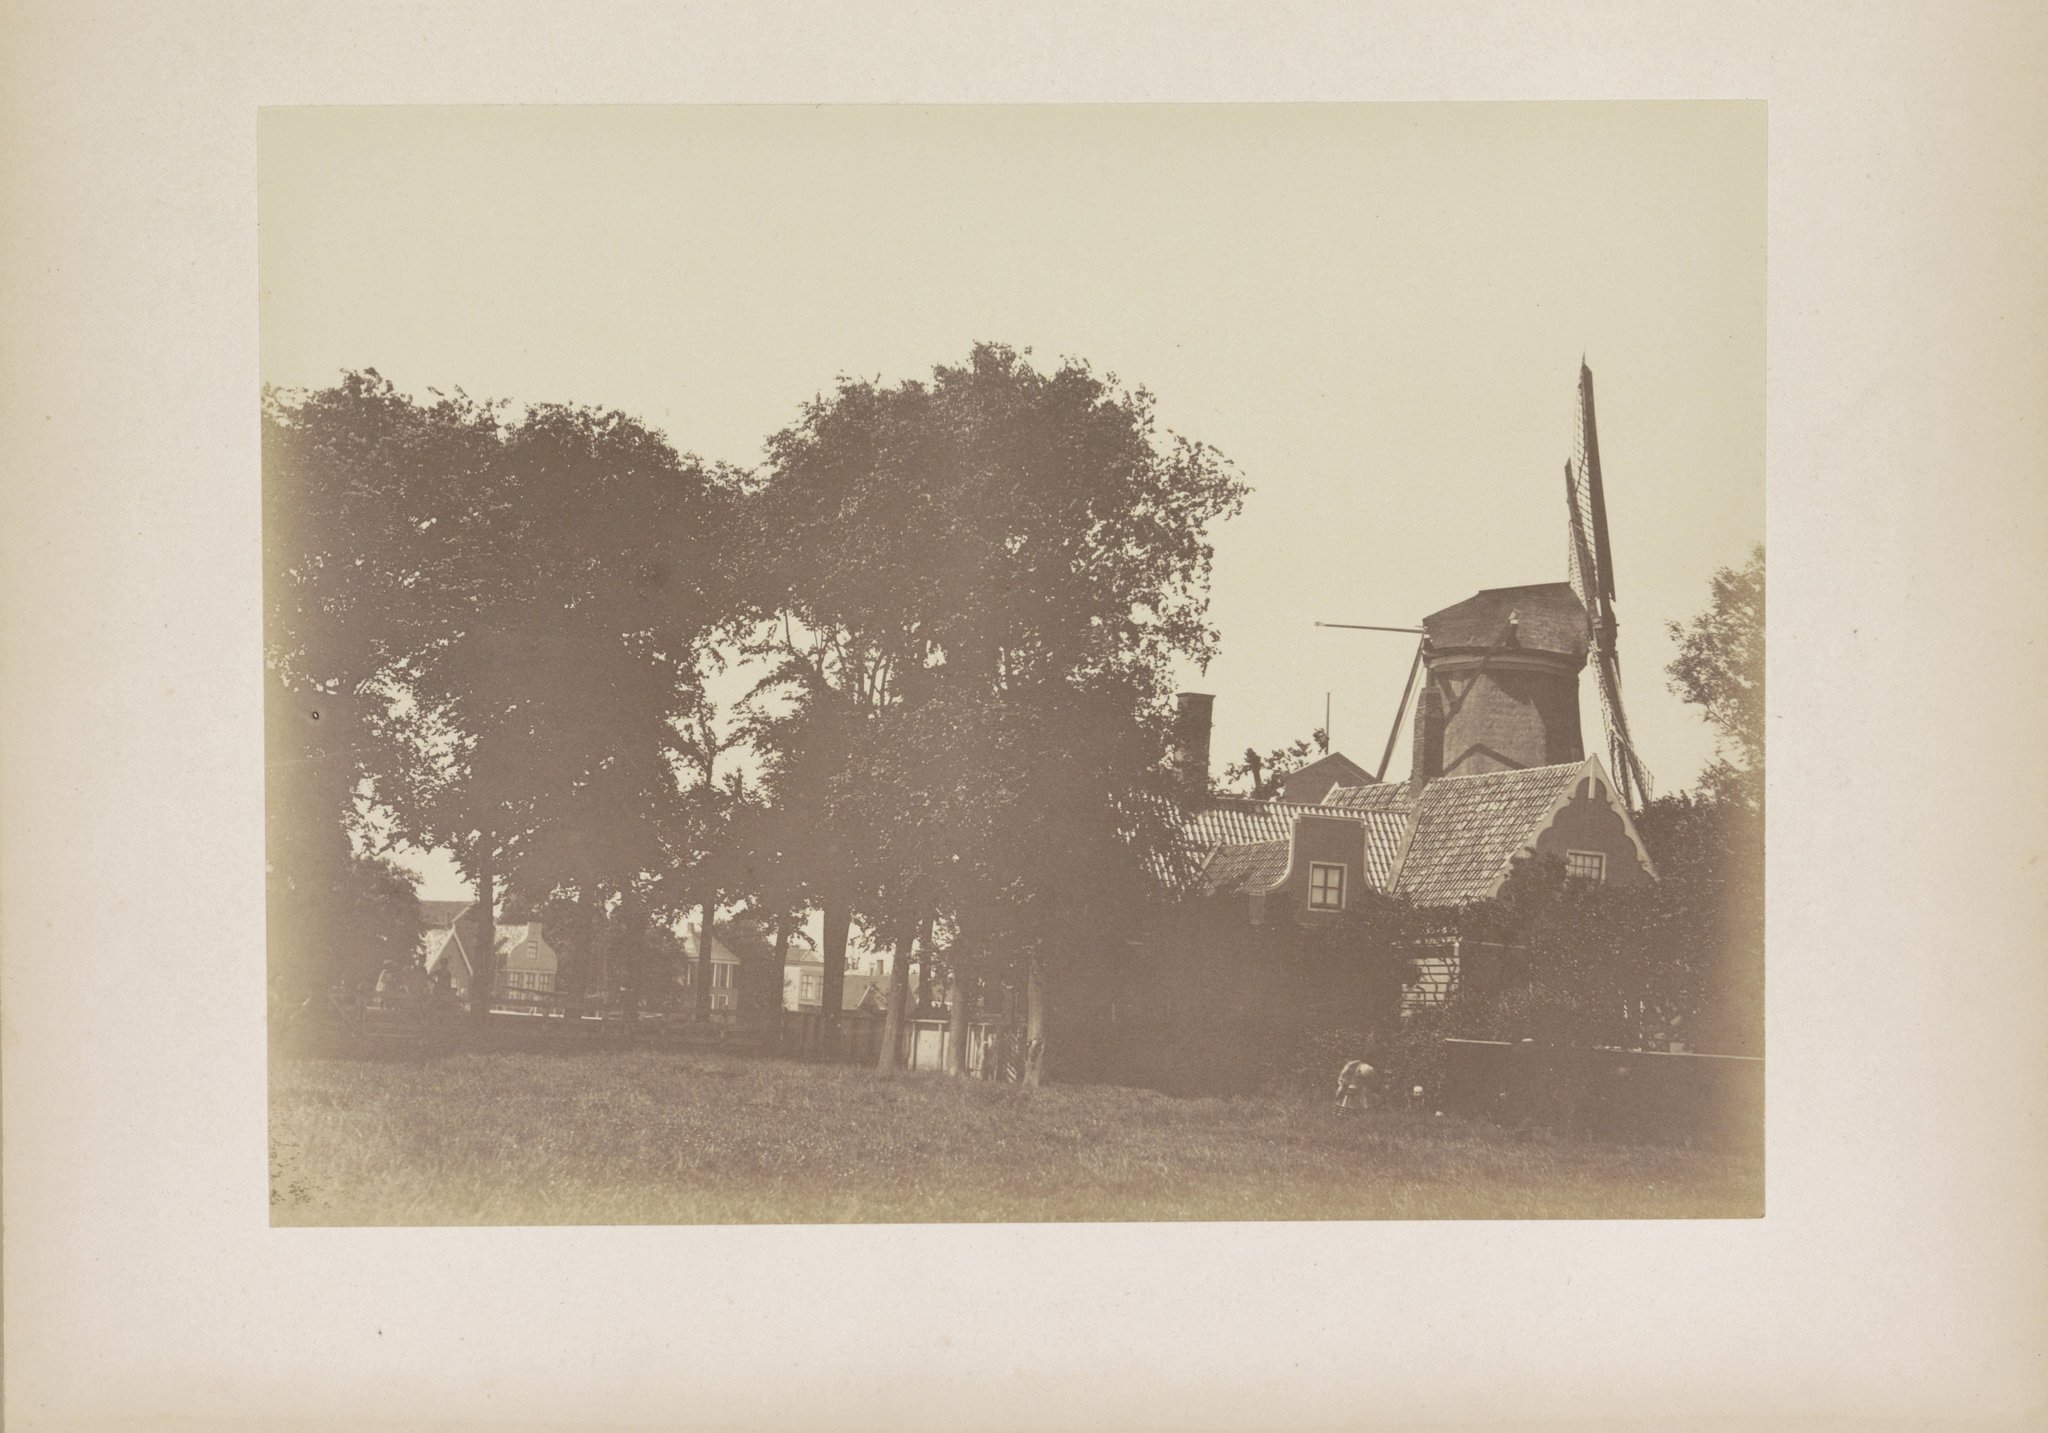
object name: photograph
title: Landschap met oliemolen De Sint Willibrordus en huisjes aan het water in Zaandam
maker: Anonymous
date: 1885-1900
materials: paper, photographic support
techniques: albumen print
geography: zaandam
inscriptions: annotation: ‘[Zaandam] / (Hollande)’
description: Landschap met op de voorgrond een weiland, rechts de oliemolen De Sint Willibrordus, bijgenaamd De Verdwaalde Boer (1669 – 1938) en enkele huizen. Links hoge bomen, huisjes aan het water en een groepje mensen in silhouet. In 1892 werd de molen verbouwd tot pelmolen. In november 1938 werd hij afgebroken tot stellinghoogte. Hij stond in Zaandam, oostzijde aan ‘t Kalf, een buurtschap in Zaandam.